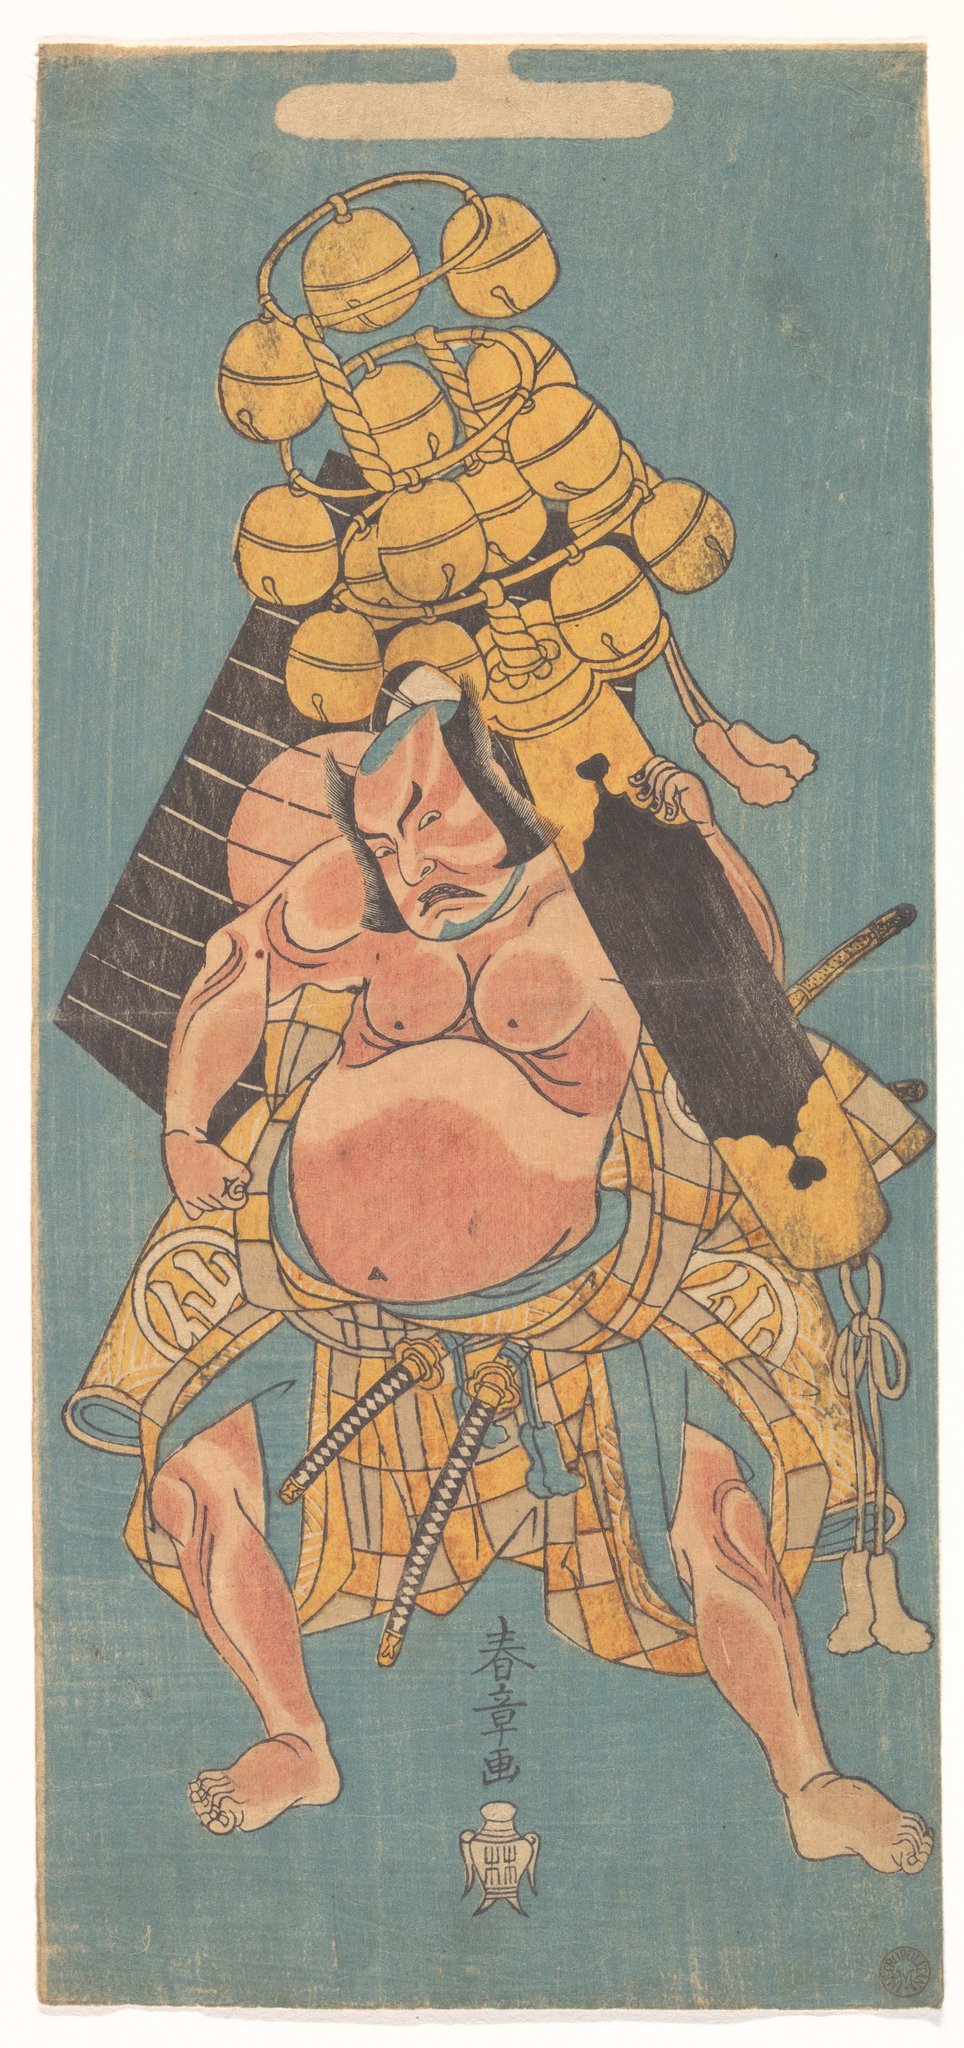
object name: woodblock print nishiki e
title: The Second Nakamura Sukegoro as a Samurai Carrying a Suzu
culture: japanese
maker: katsukawa shunshō 勝川春章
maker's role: artist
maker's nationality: japanese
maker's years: 1726-1792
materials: ink, paper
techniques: nishiki e, woodblock print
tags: men,actors,bells